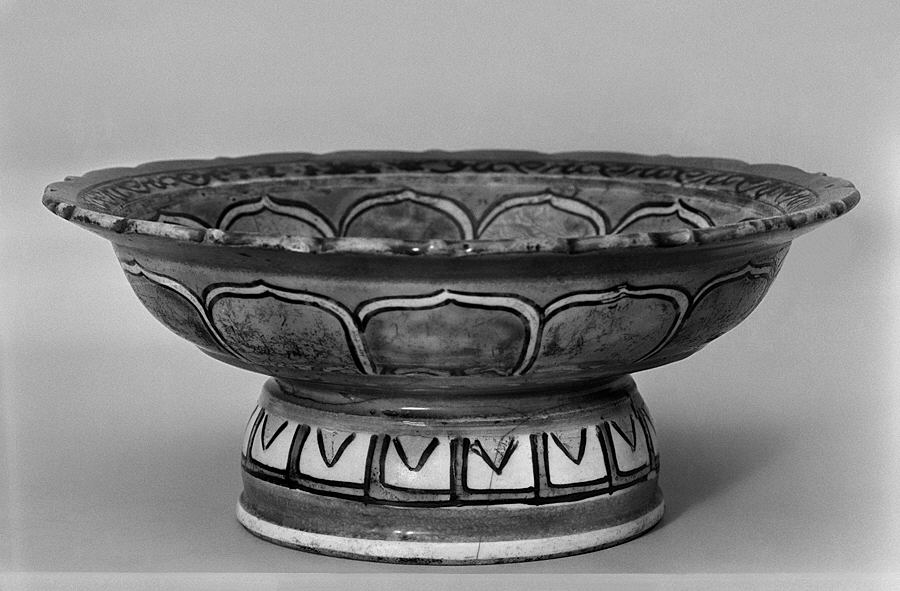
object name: dish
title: Footed Dish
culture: chinese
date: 1767-1900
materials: enamel, porcelain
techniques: overglaze, painting, polychrome